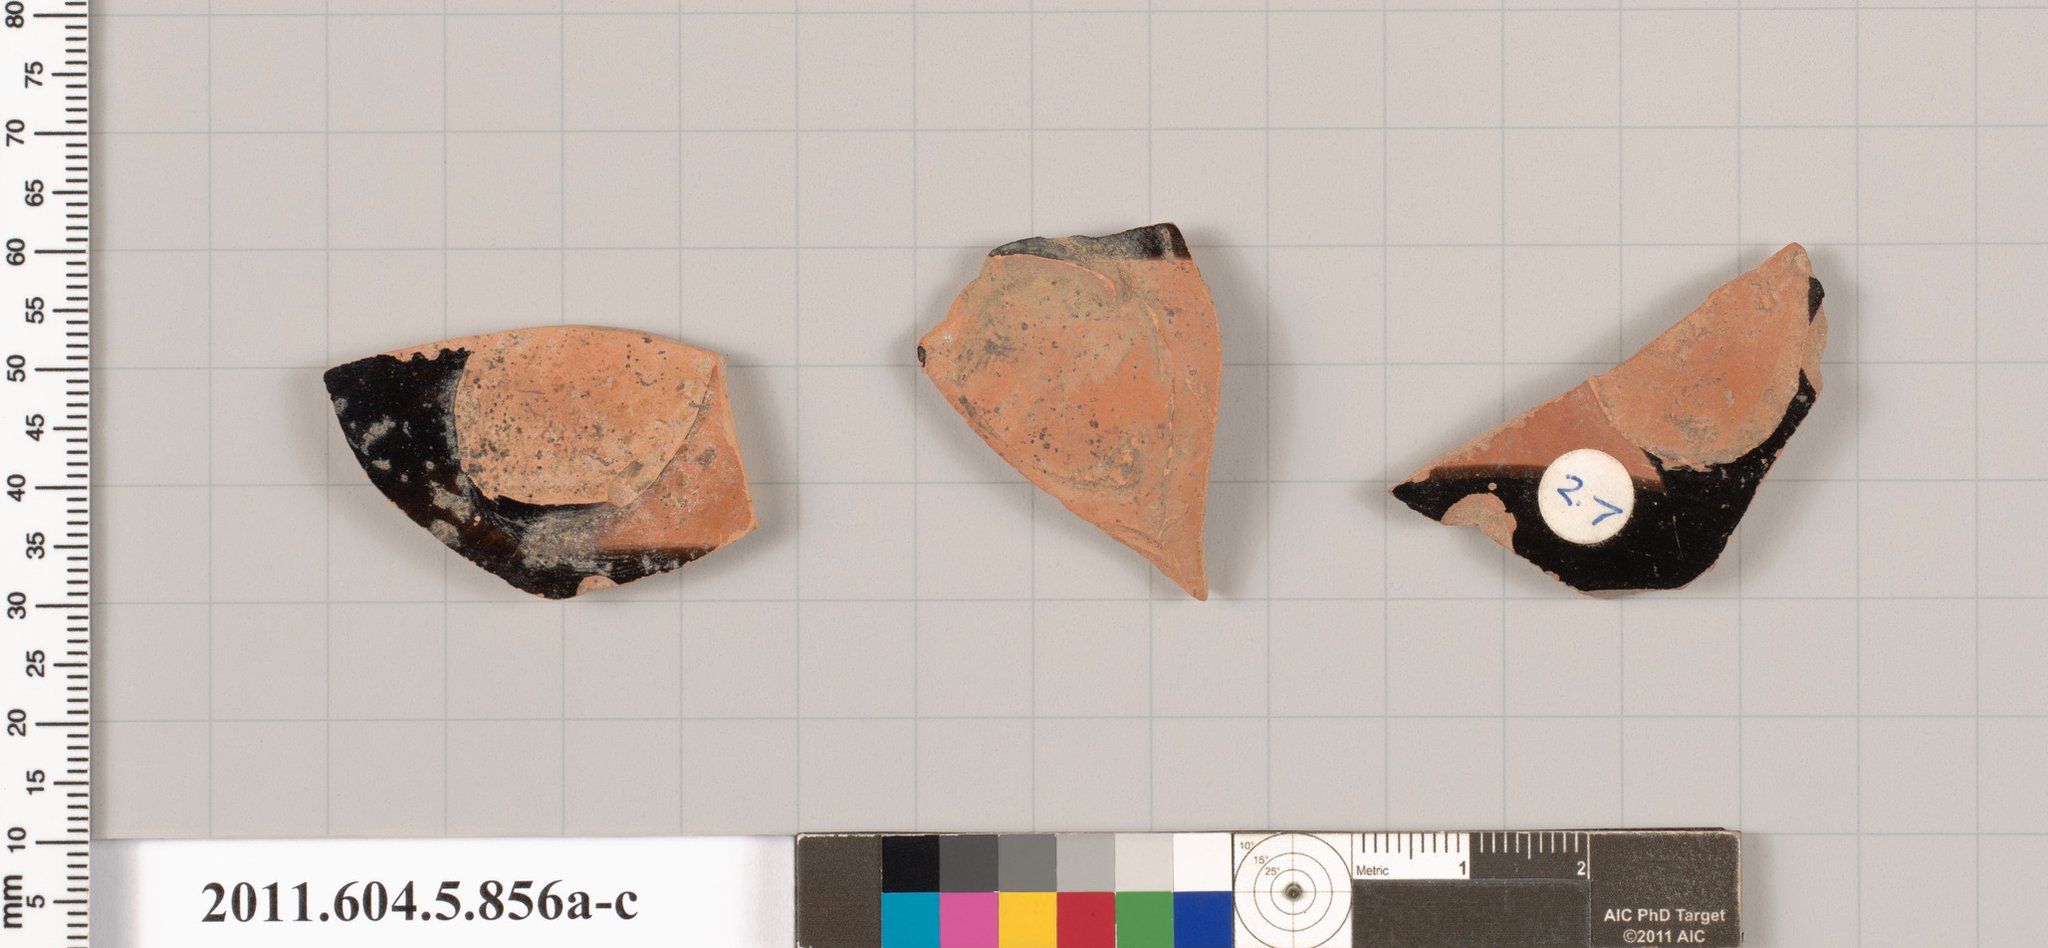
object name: kylix fragment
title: Terracotta fragments of kylikes (drinking cups)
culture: greek, attic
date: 600-401 BCE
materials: terracotta